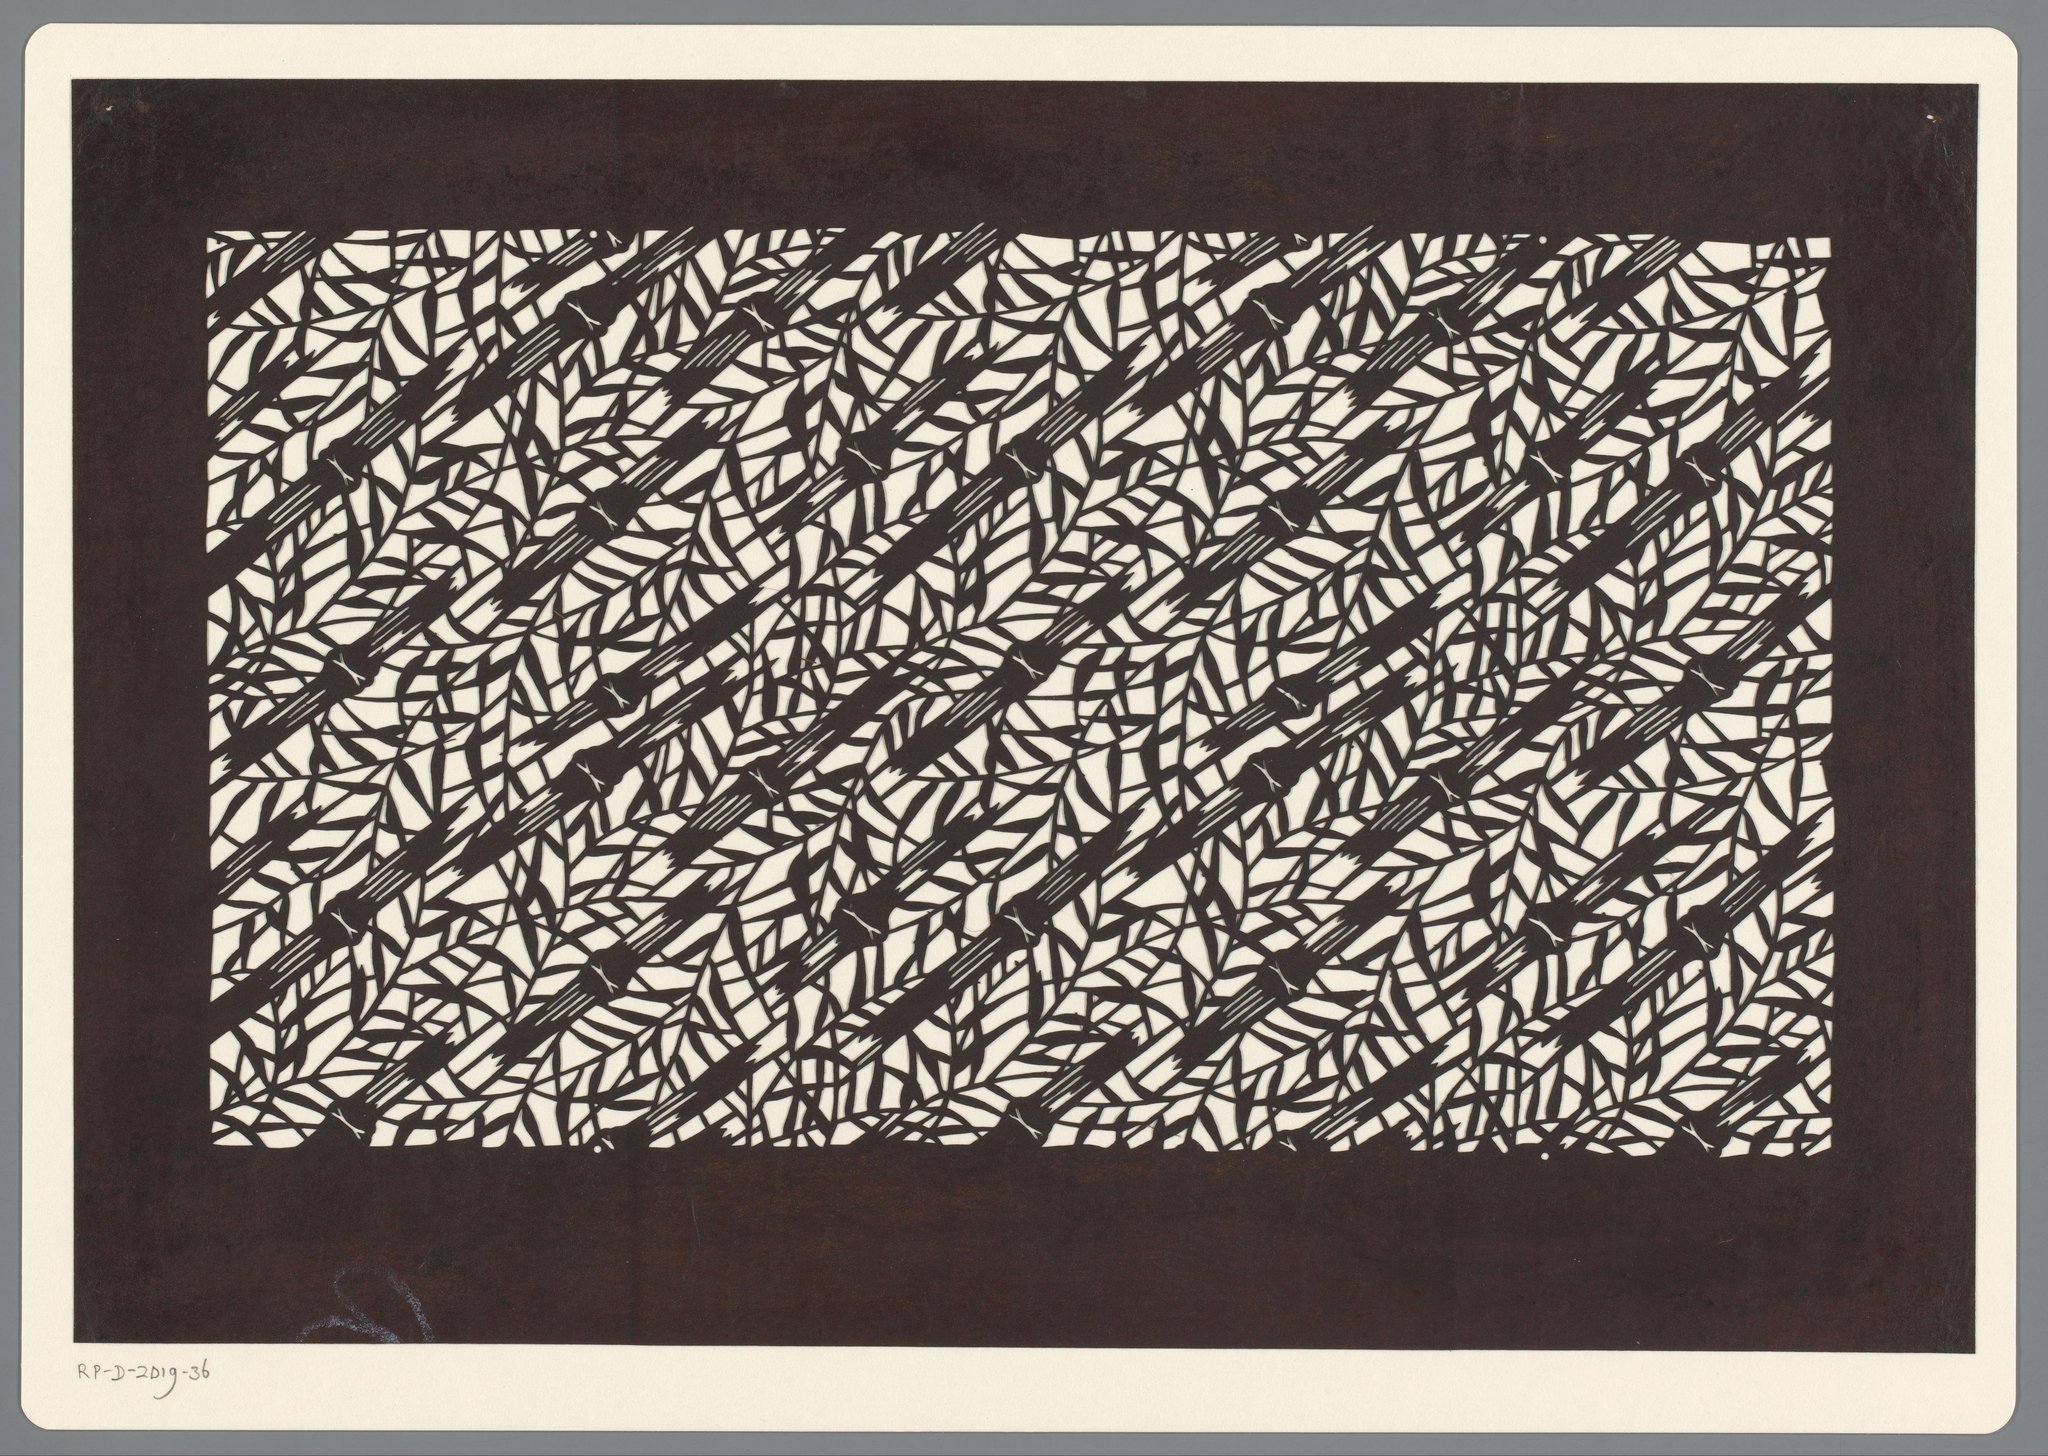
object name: katagami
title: Sjabloon met bamboe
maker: Anonymous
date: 1800-1909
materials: paper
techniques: cutting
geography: japan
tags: plants and herbs: bamboo, foliage, tendrils, branches ~ ornament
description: Japanse sjabloon (katagami) met een uniform diagonaal patroon van bamboebladeren en stengels.